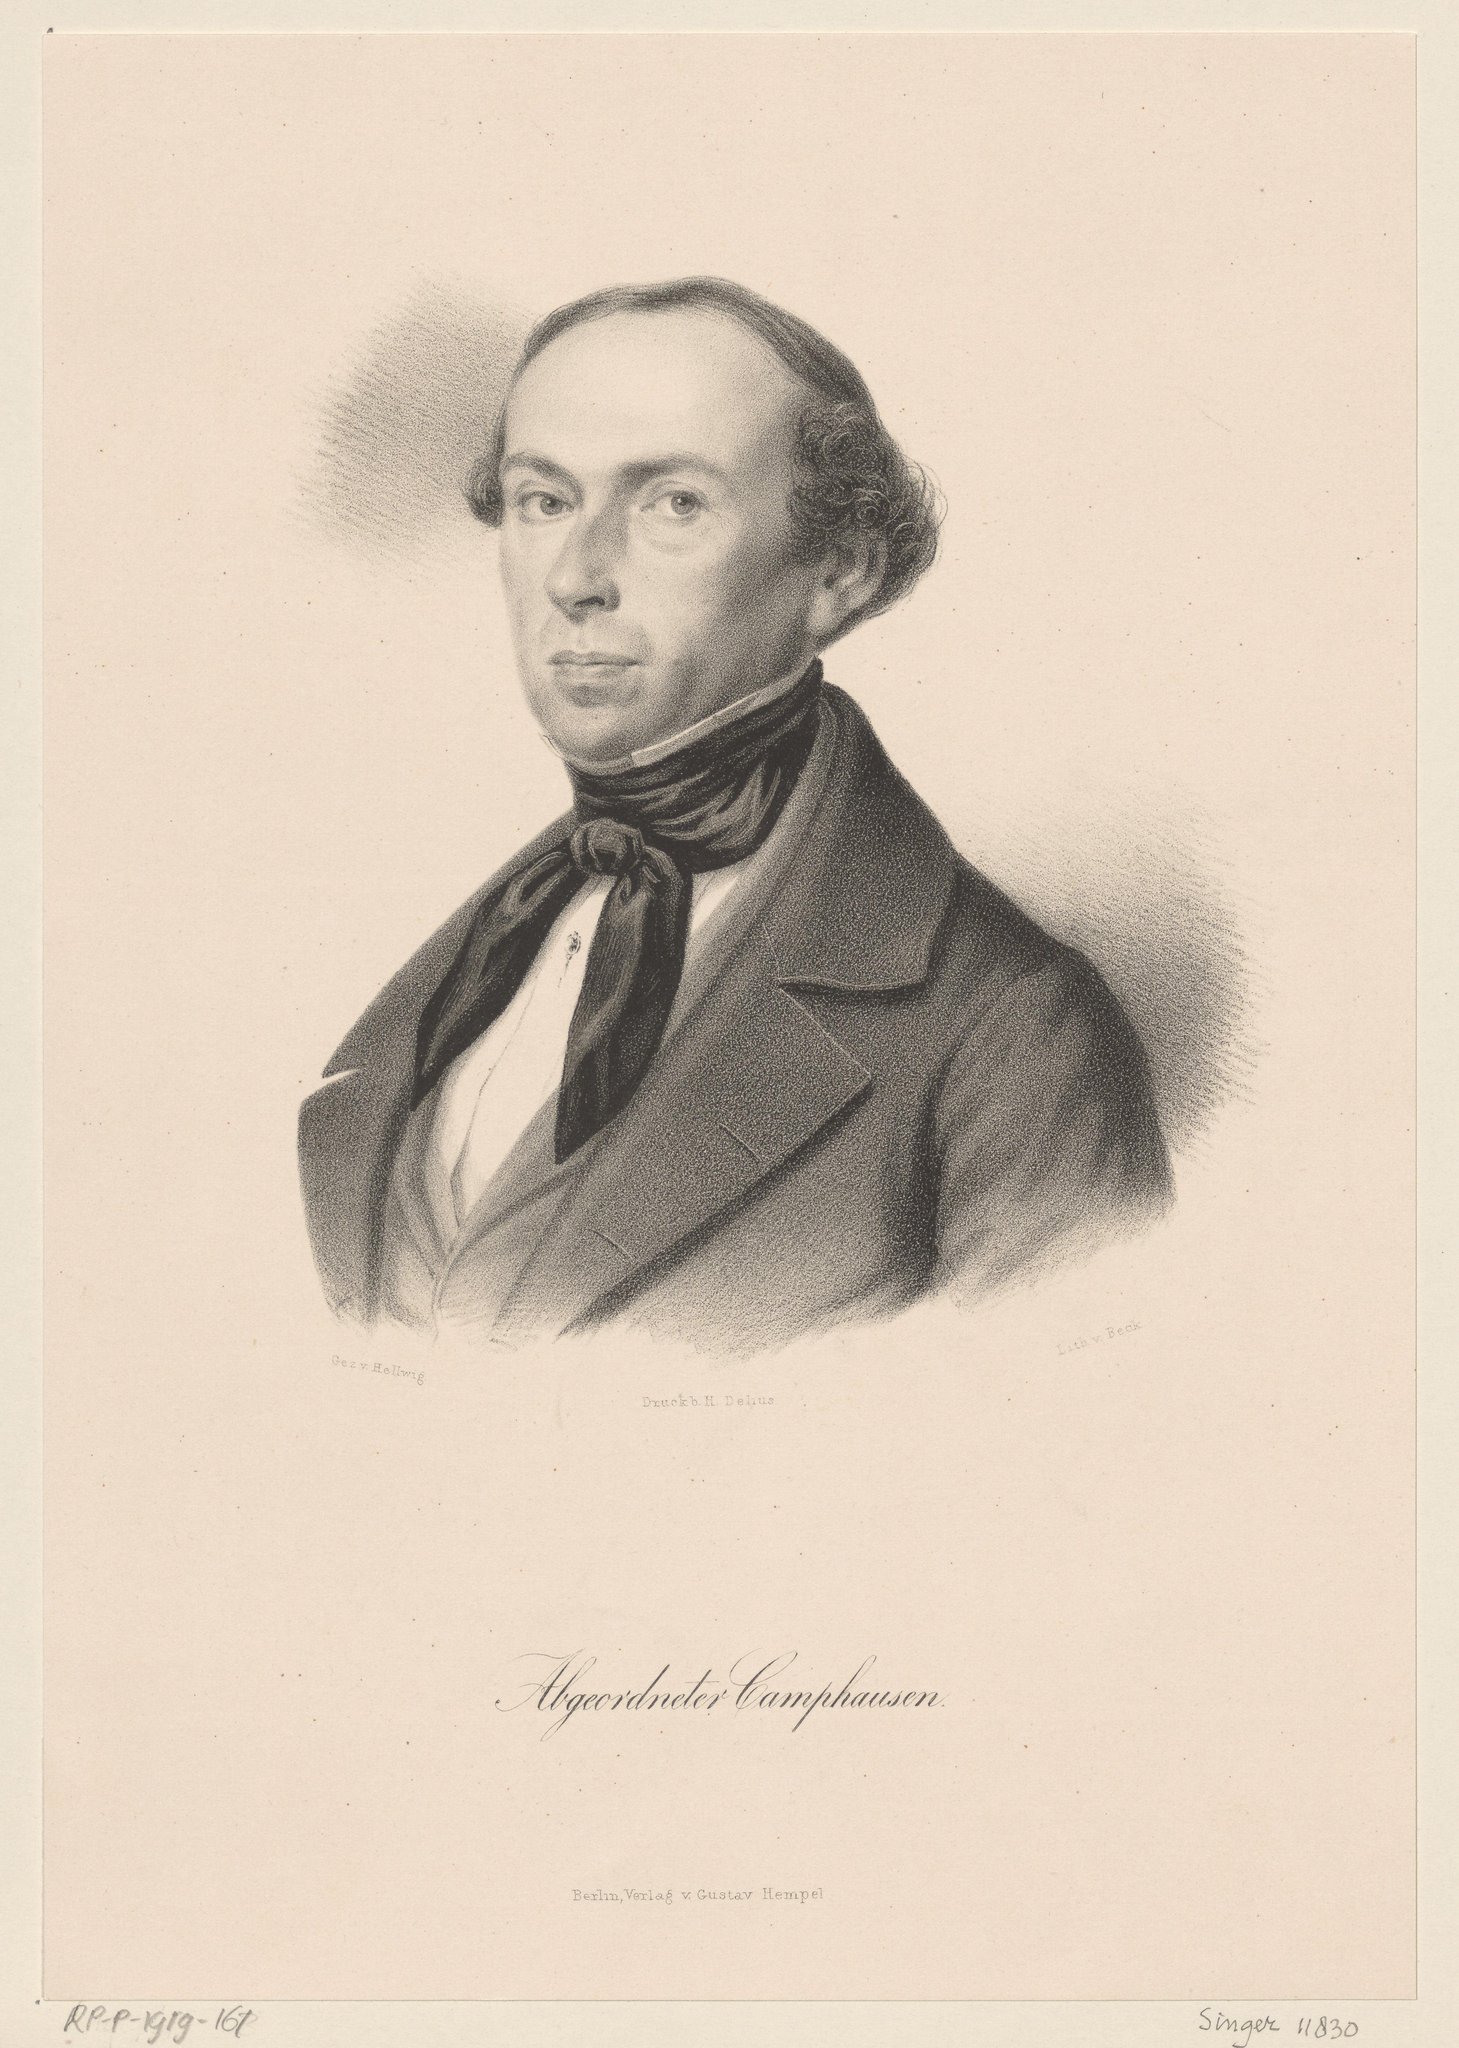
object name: print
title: Portret van Gottfried Ludolf Camphausen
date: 1847-1877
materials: paper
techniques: lithograph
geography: berlin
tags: historical persons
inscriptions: collector's mark: Lugt 2228